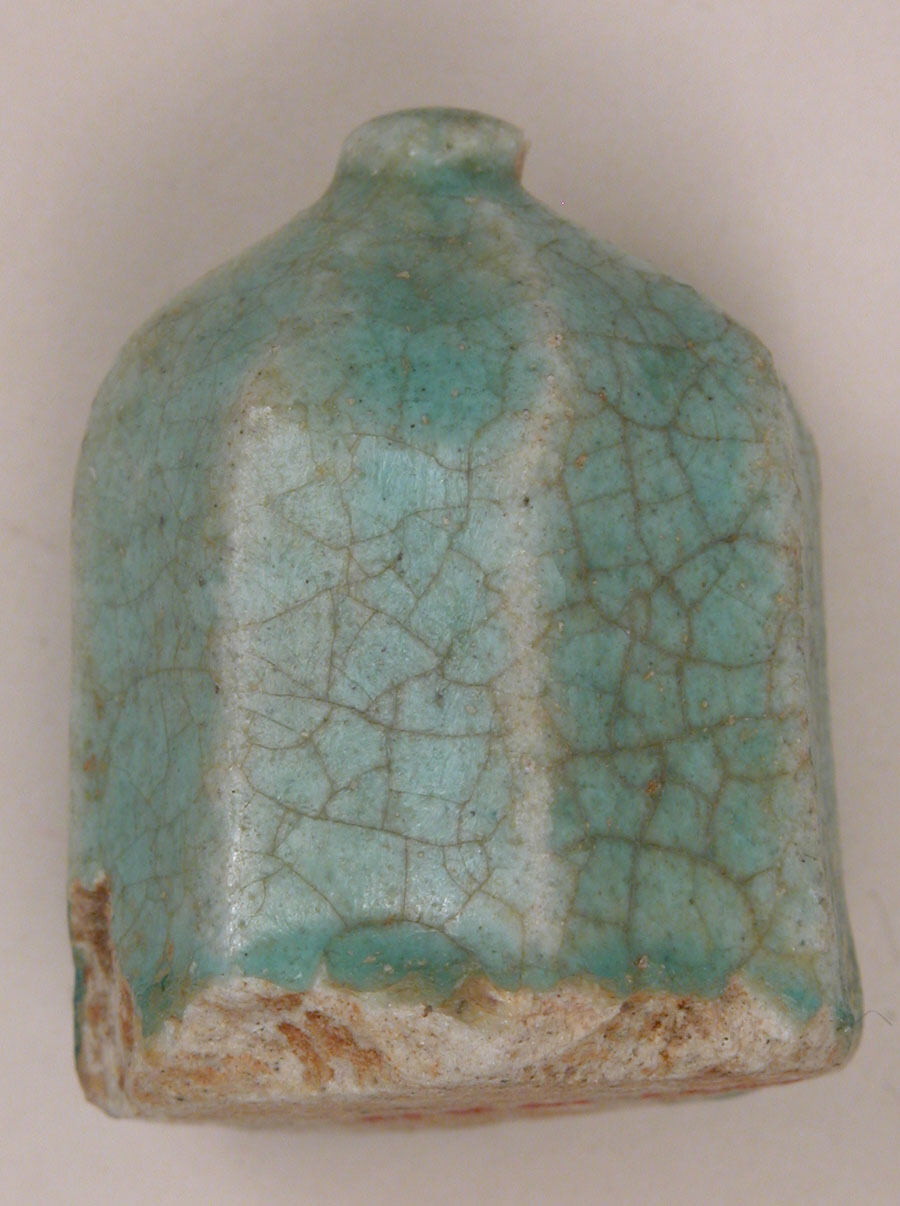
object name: chess piece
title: Chess Piece, Pawn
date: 1101-1200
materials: earthenware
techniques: glazing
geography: iran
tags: chess,games